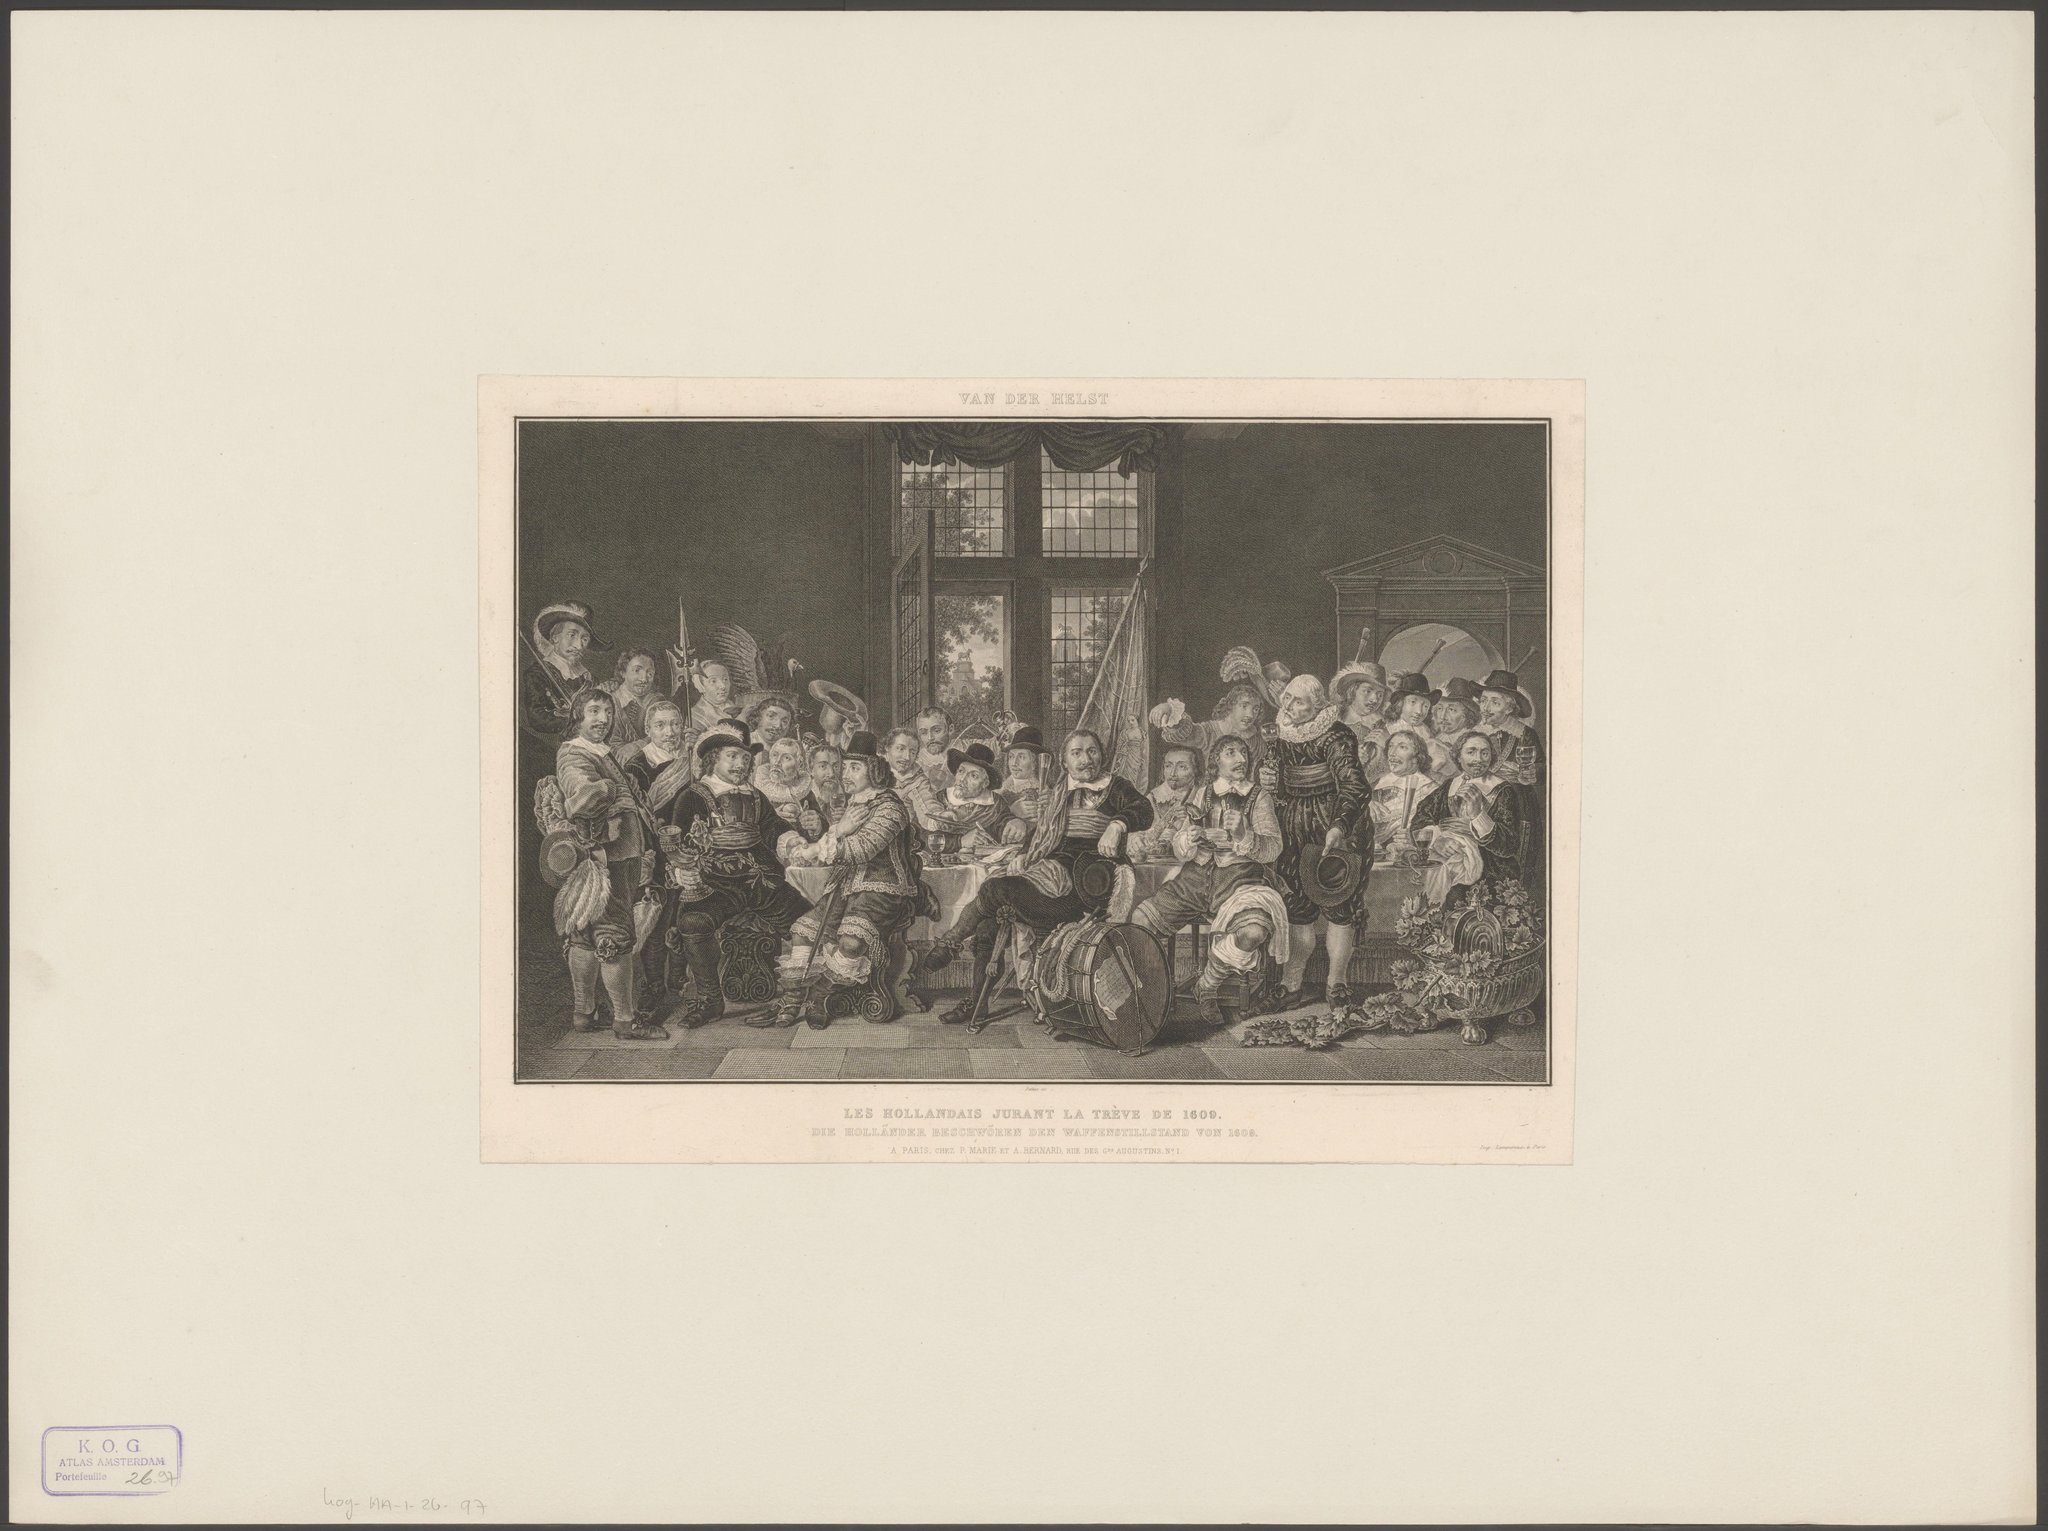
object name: print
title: Van der Helst / Les Hollandais jurant la trève de 1609 / Die Holländer beschwören den waffenstillstand von 1609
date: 1825-1875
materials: paper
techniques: etching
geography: paris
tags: amsterdam, mayor, cornelis witsen, historical persons, (military) standard-bearer, warfare; military affairs (+ citizen soldiery, civil guard, citizen militia), celebration meal, feast, banquet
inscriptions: collector's mark: Lugt 1641b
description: Onderwerpsrubriek binnen de Atlas Amsterdam: Herinneringen aan de Schutterij.